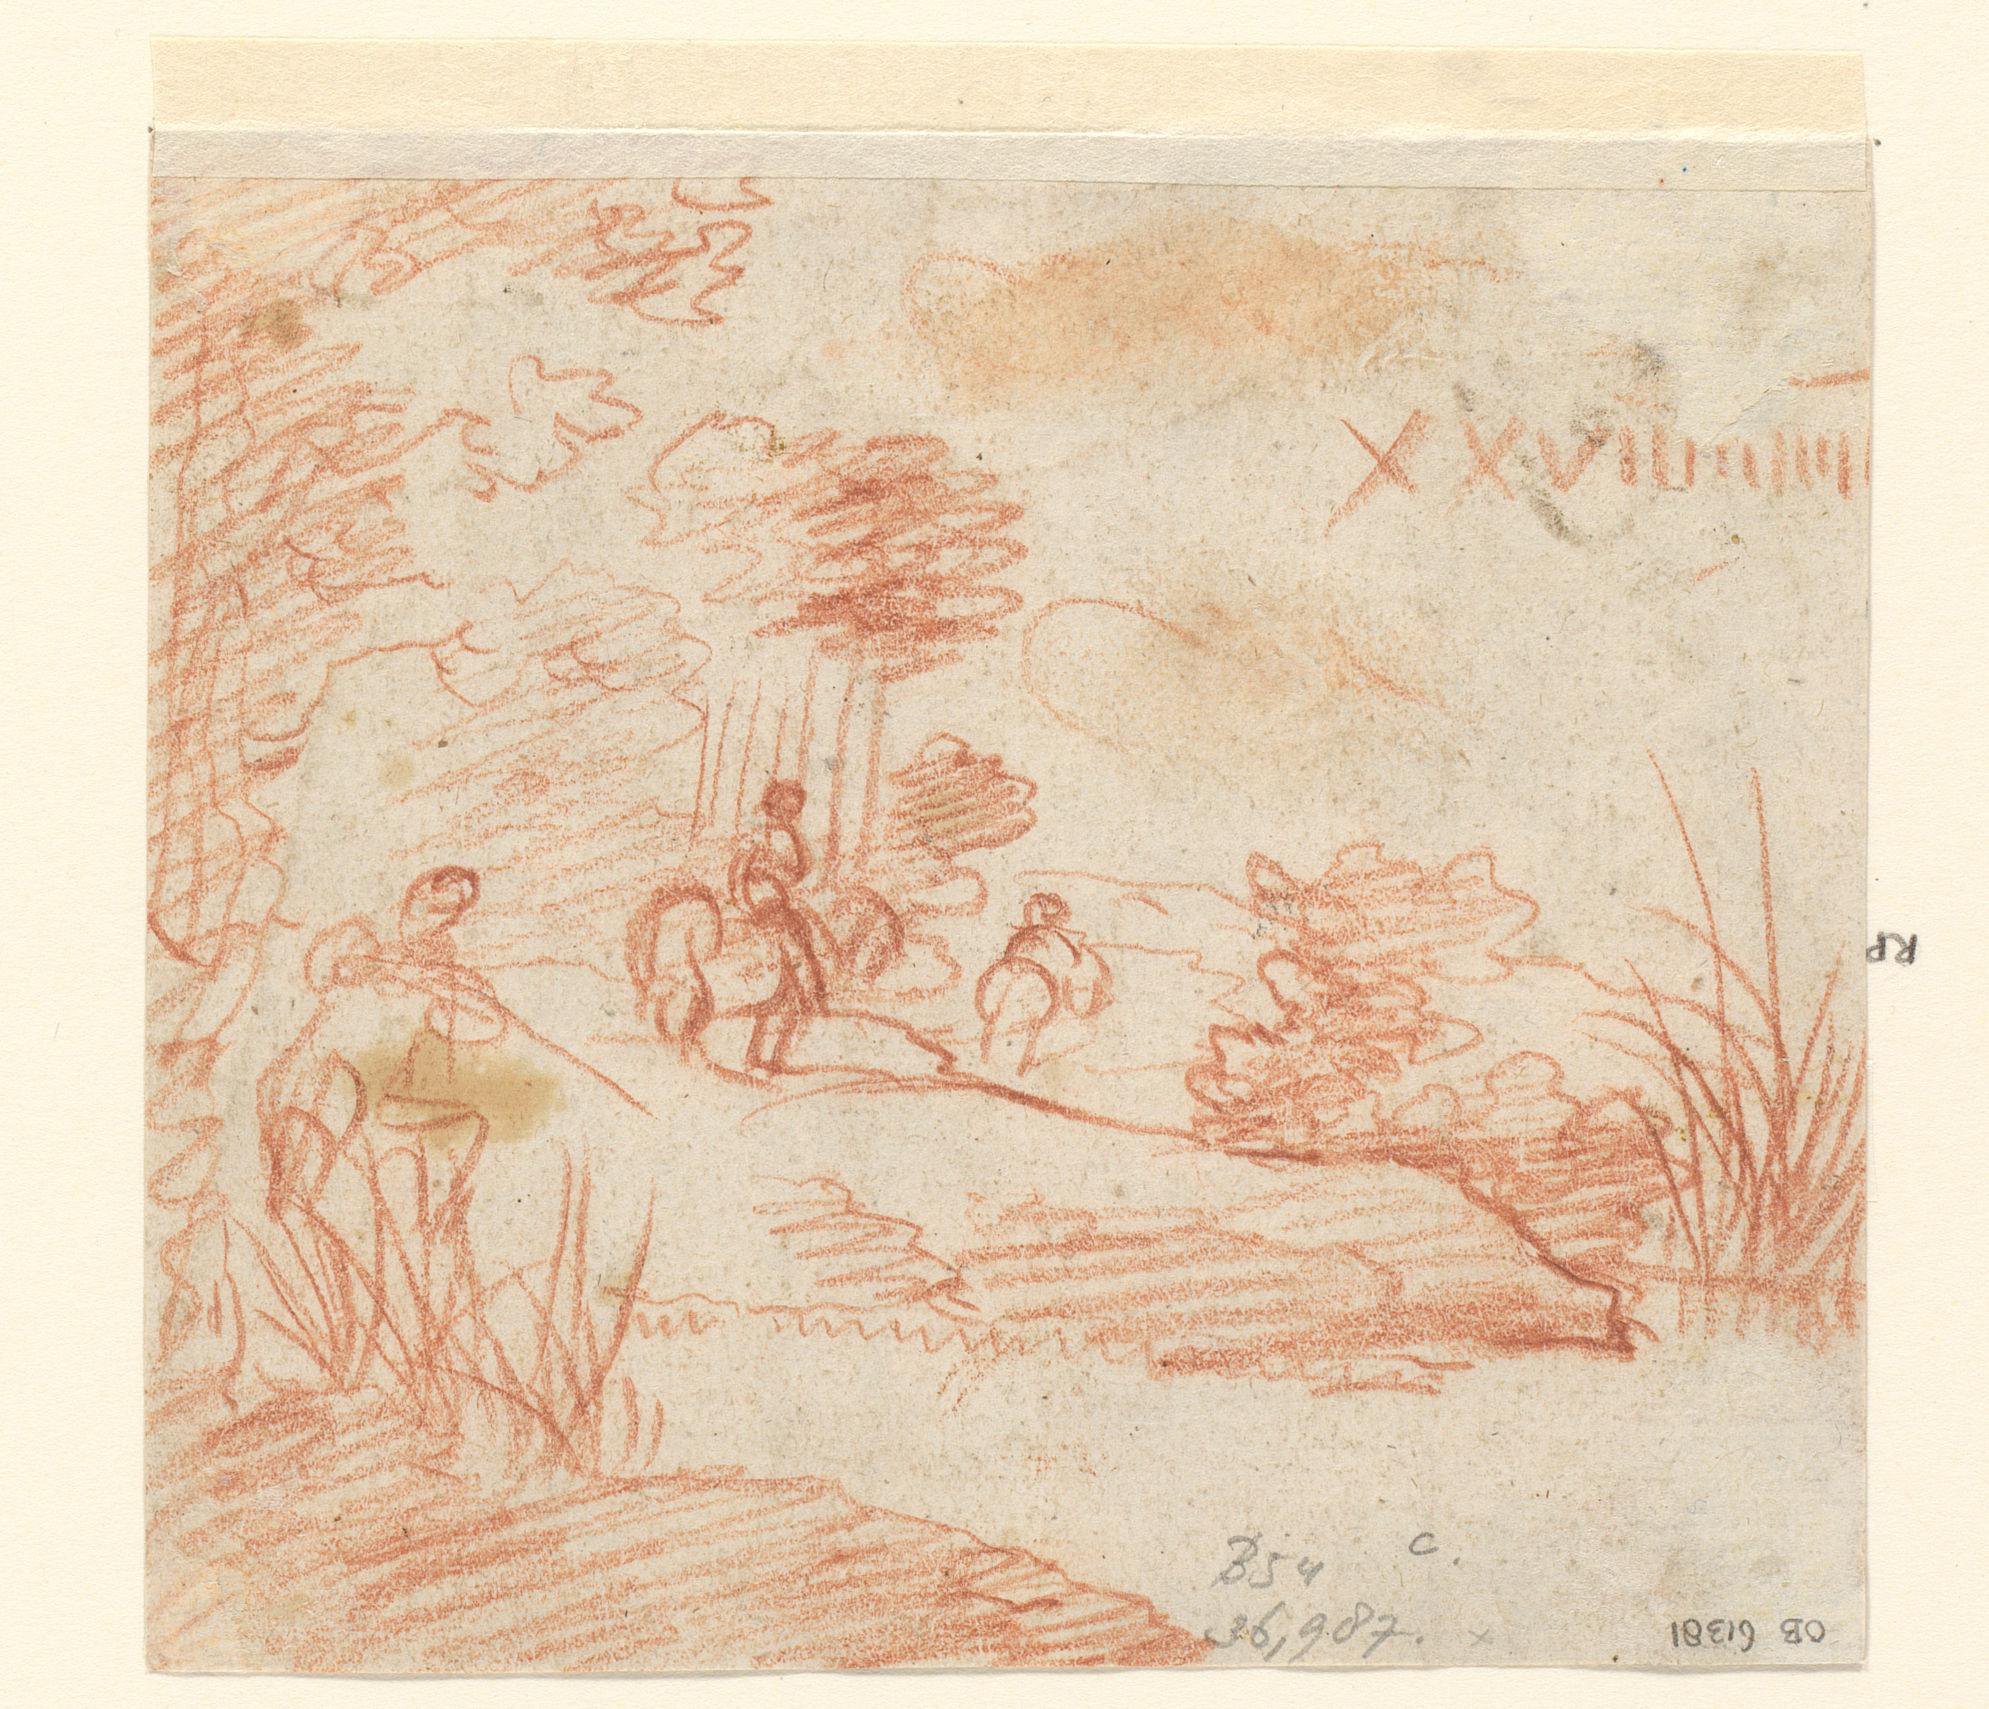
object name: drawing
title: Landschap met ruiters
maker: anthonie waterloo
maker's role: draughtsman, painter, print maker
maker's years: 1609-1690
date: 1630-1663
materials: chalk, paper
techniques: etching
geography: amsterdam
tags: riding a horse, ass, or mule; rider, horseman, low hill country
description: Zie RP-P-OB-61.381(R) voor rectozijde. Zie Hollstein voor een volledig overzicht van de verschillende edities.